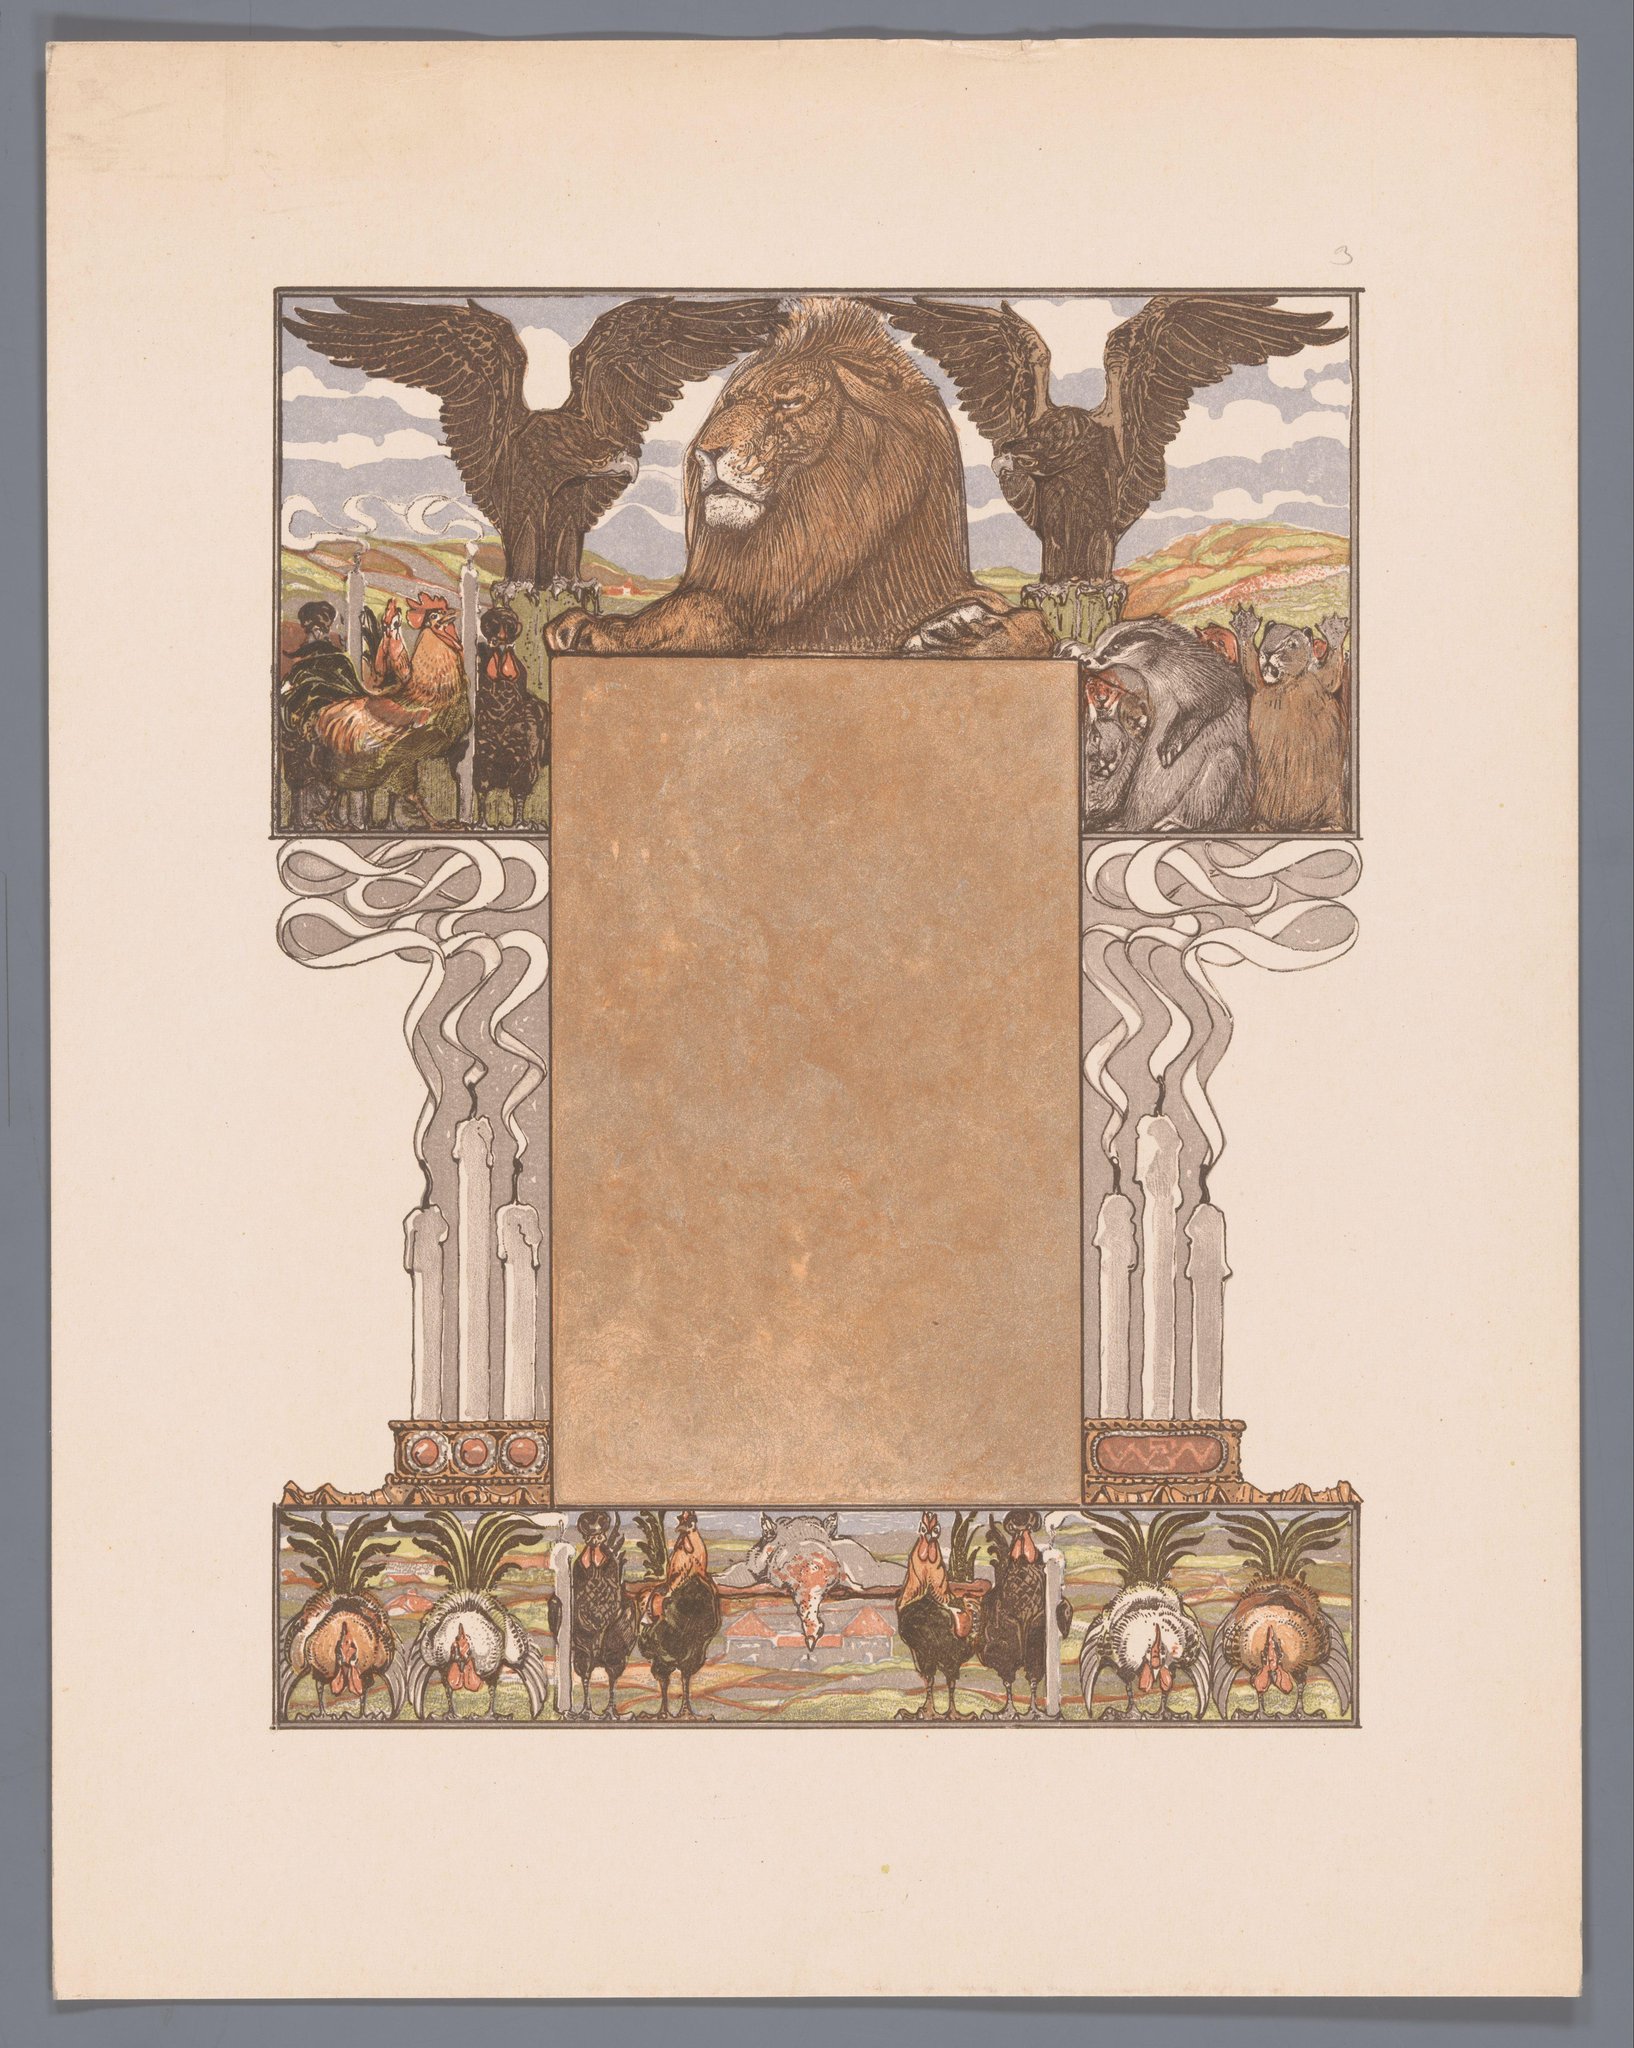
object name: boekillustratie ontwerp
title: Gedoofde kaarsen en leeuw (Nobel) geflankeerd door adelaars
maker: bernard willem wierink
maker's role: draughtsman, print maker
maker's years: 1856-1939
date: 1910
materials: paper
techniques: lithograph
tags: fable of reynard the fox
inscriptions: collector's mark: Lugt 2228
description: Ontwerp voor: Streuvels, Stijn (Frank Lateur). Reinaert de Vos naar verschillende uitgaven van het middeleeuwsche epos. Amsterdam: L.J. Veen, 1910.